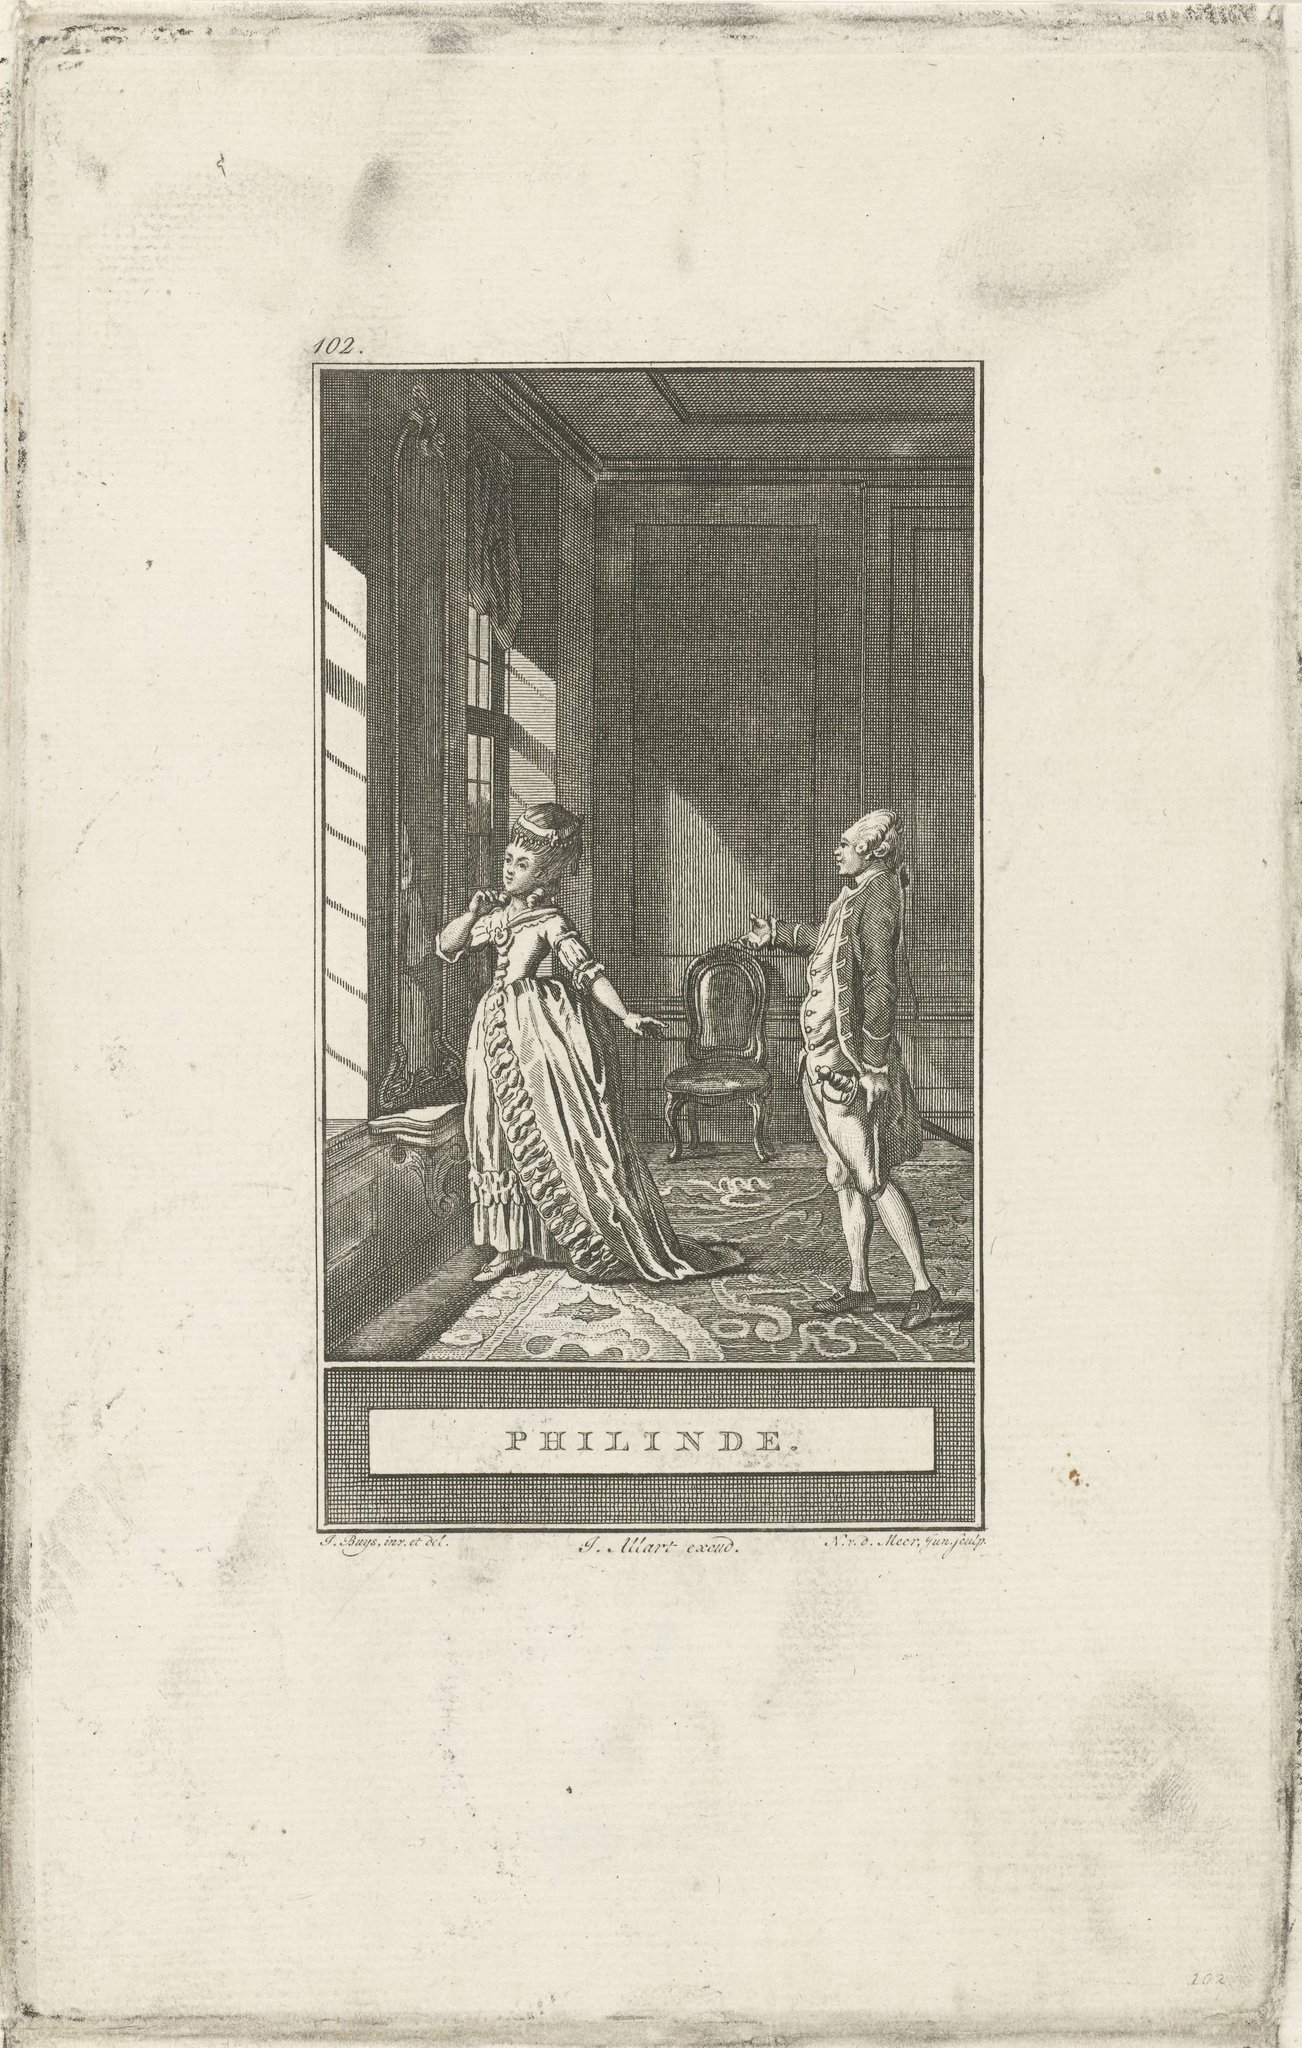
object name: book illustration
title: Philinde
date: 1778-1785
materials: paper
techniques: etching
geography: amsterdam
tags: looking in the mirror; (possibly: contemplation of own beauty - aa - (for) women), complacency, self-conceit, brothers or sisters (second degree family relationships)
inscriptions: collector's mark: Lugt 2228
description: Prent bij: Gellert, Christian Fürchtegott. Fabelen en vertelsels. 3 dln. Amsterdam: Pieter Meyer, 1772-1774. De prenten bij deze publicatie werden later uitgegeven. De exemplaren uitgegeven door de weduwe Jacobus Loveringh & Johannes Allart tussen 1777 en 1778, de exemplaren uitgegeven door alleen Johannes Allart tussen 1778 en 1785.